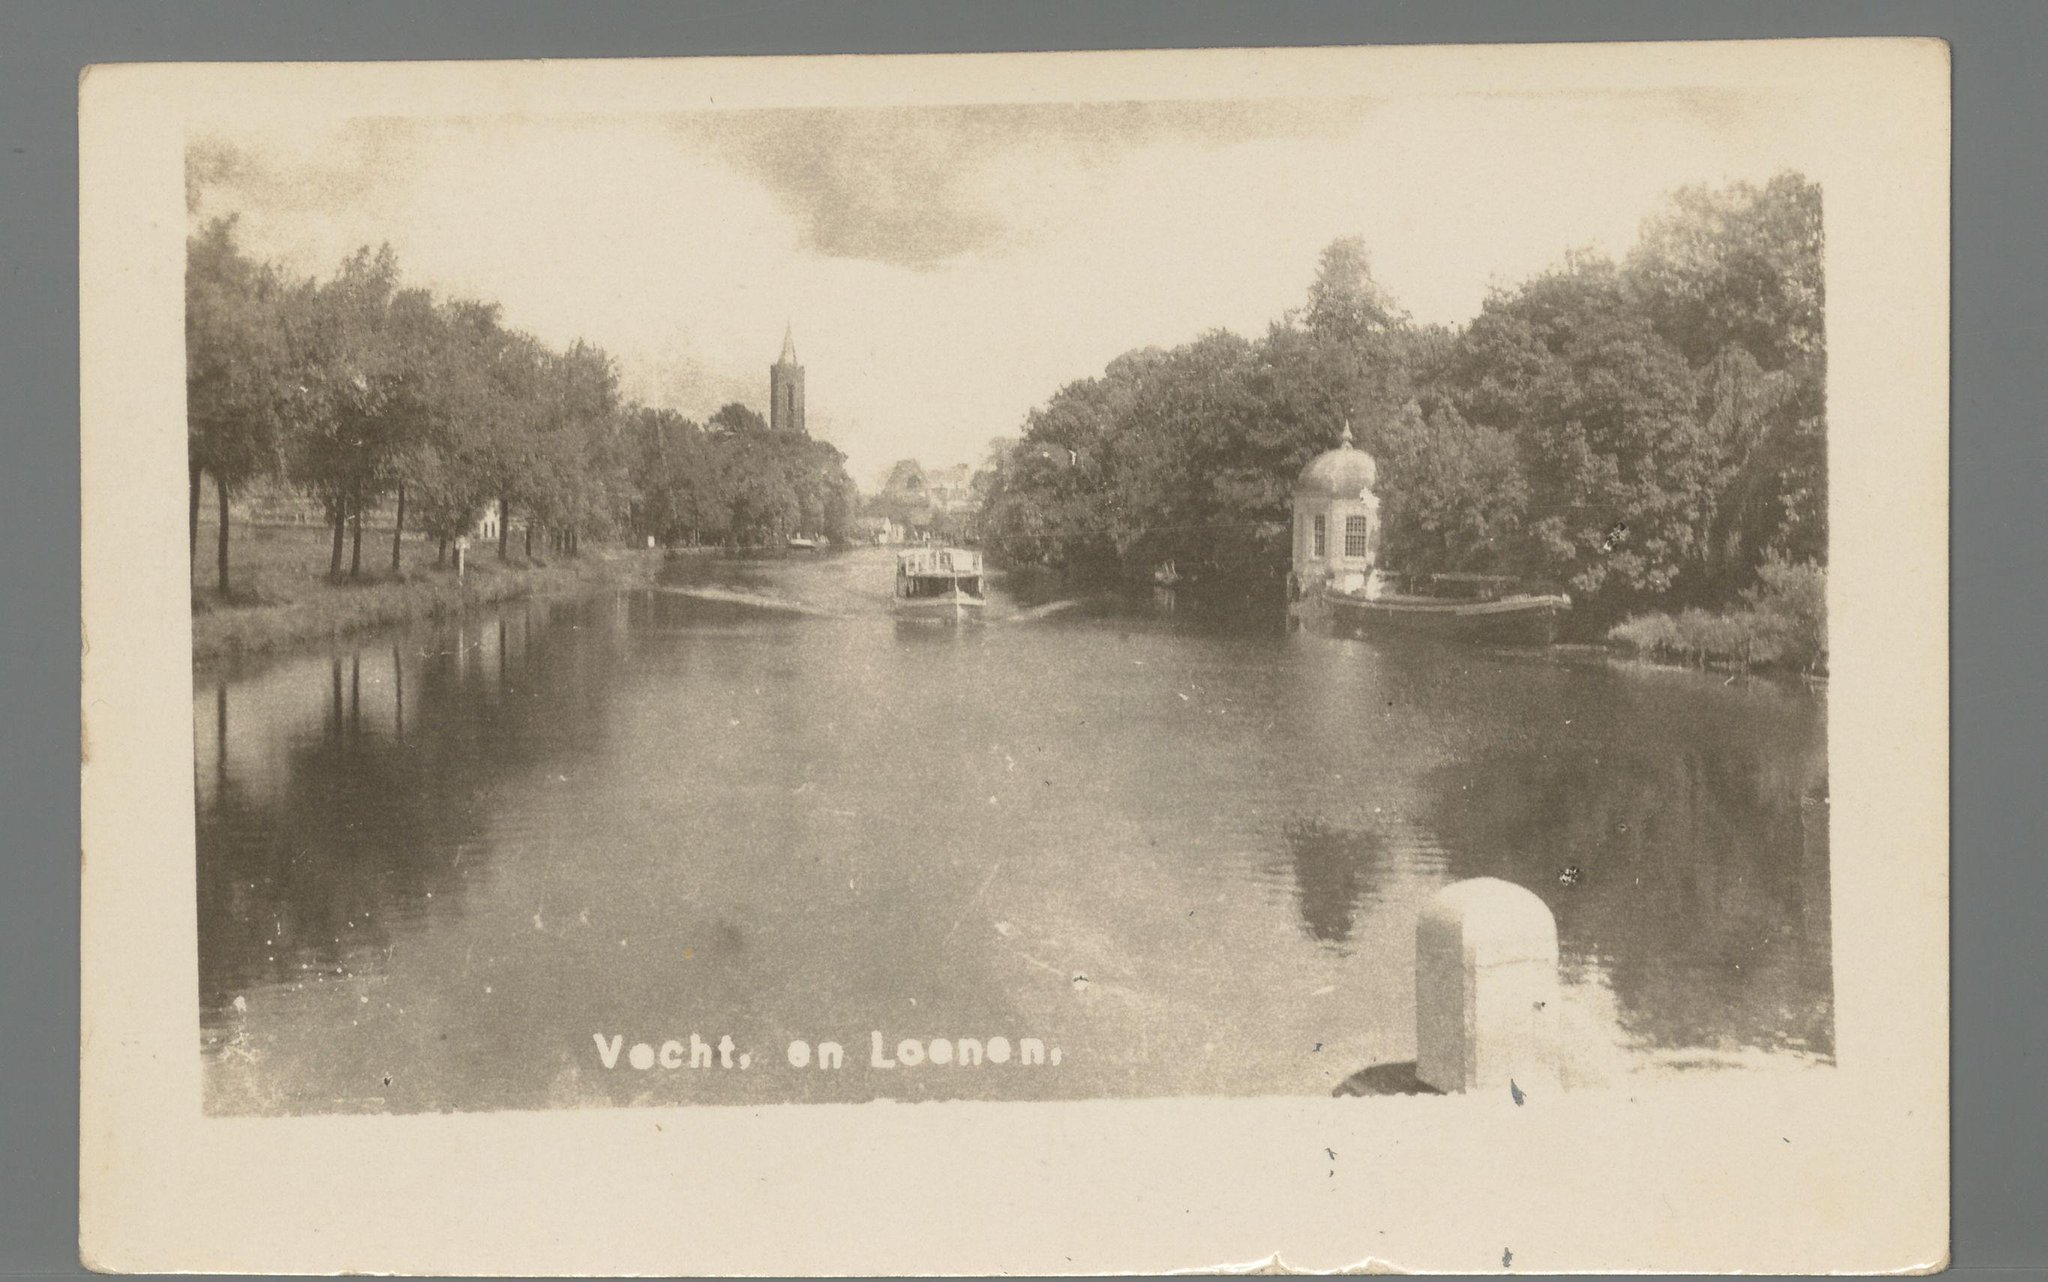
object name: ansichtkaart, prentbriefkaart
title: Vecht, en Loenen.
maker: Anonymous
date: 1900-1936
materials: photographic support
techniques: photography, writing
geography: amsterdam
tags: river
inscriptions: postage stamp